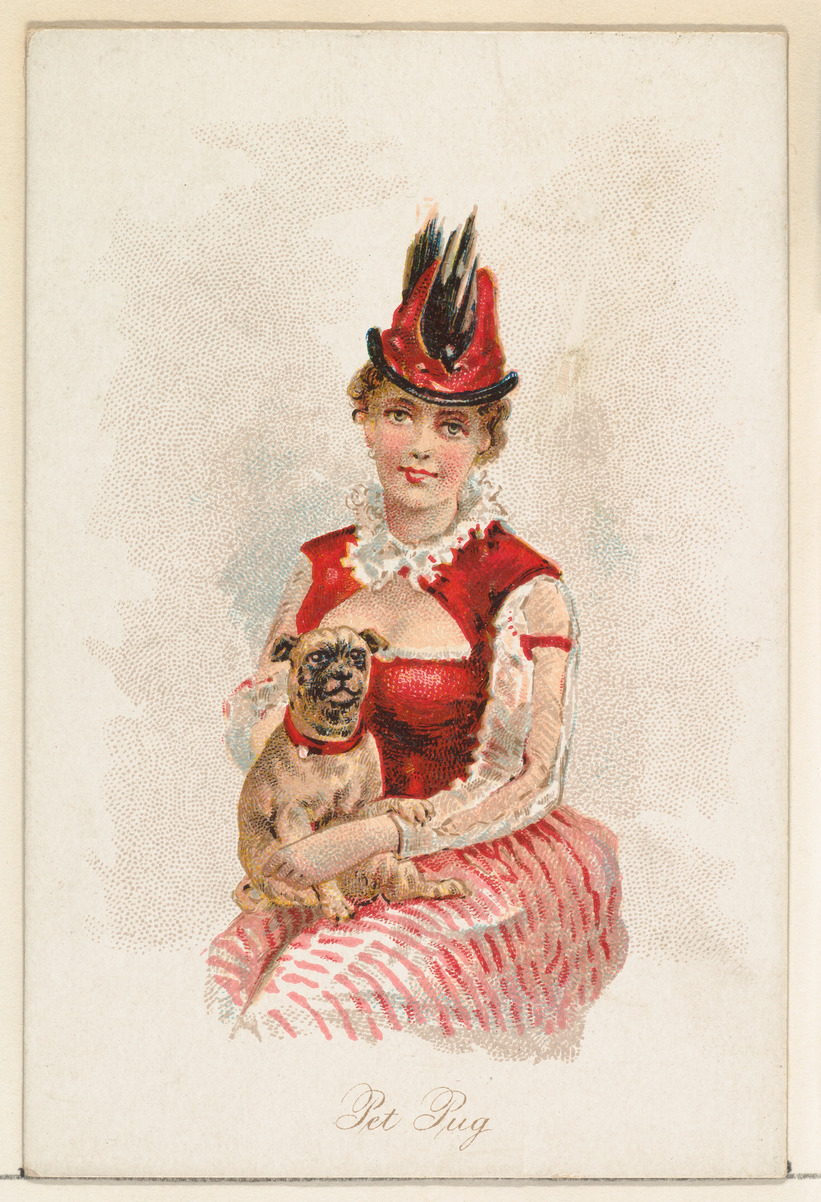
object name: print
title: Pet Pug, from the Household Pets series (N194) issued by Wm. S. Kimball & Co.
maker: william s. kimball & company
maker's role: publisher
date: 1891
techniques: color lithograph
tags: women,dogs